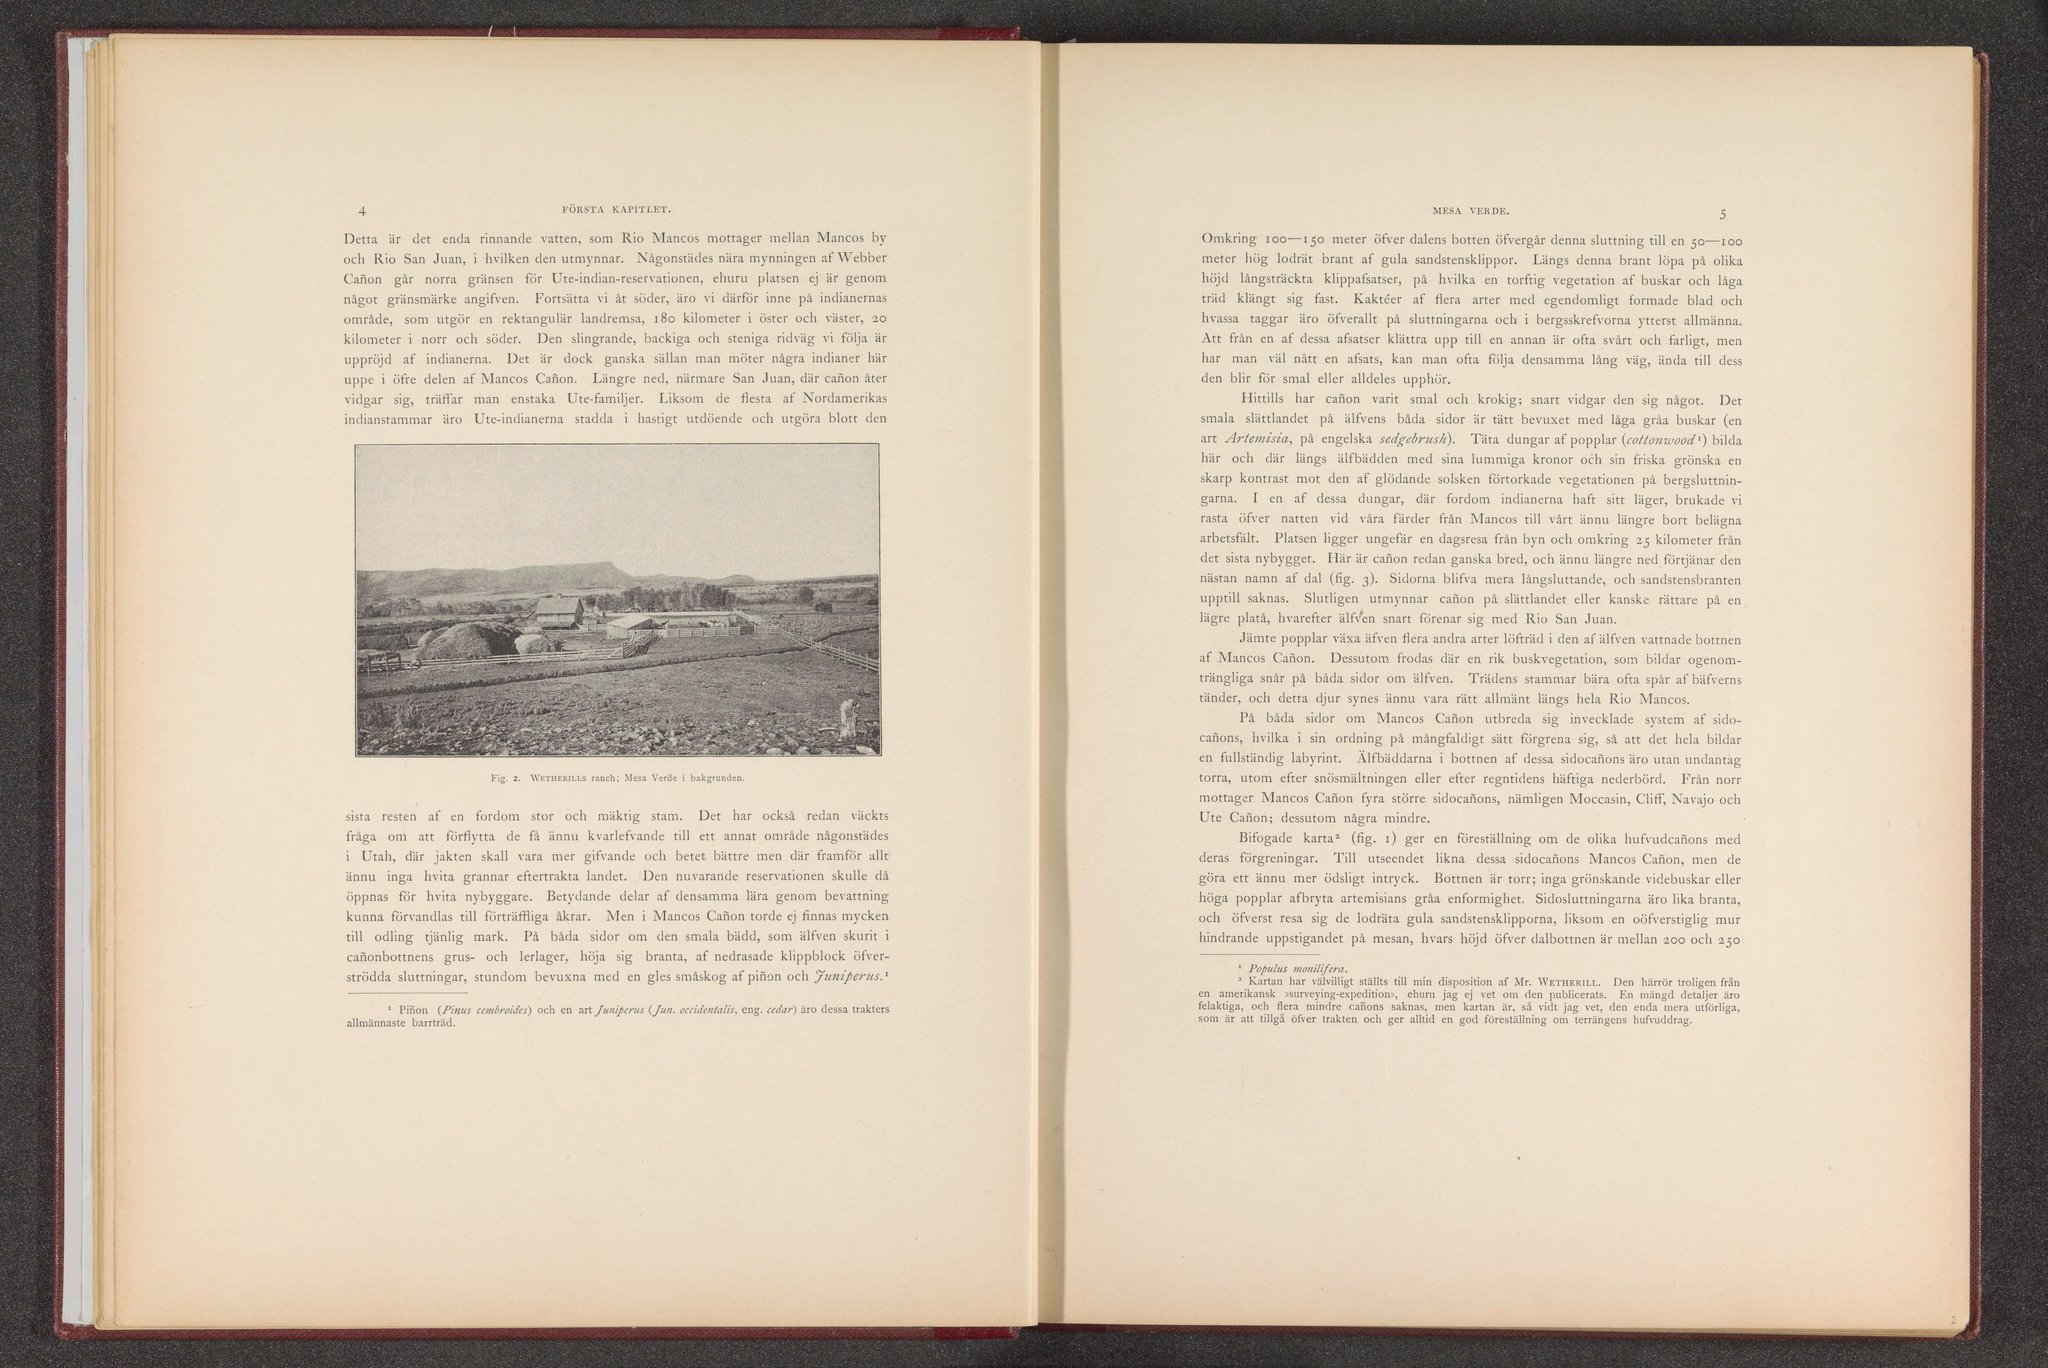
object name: page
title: Wetherills ranch; Mesa verde i bakgrunden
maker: gustaf nordenskiöld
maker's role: fotograaf, schrijver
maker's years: 1868-1895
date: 1891-1893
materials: paper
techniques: autotype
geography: mesa verde national park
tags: farm or solitary house in landscape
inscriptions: inscription: ‘Fig. 2.’, name